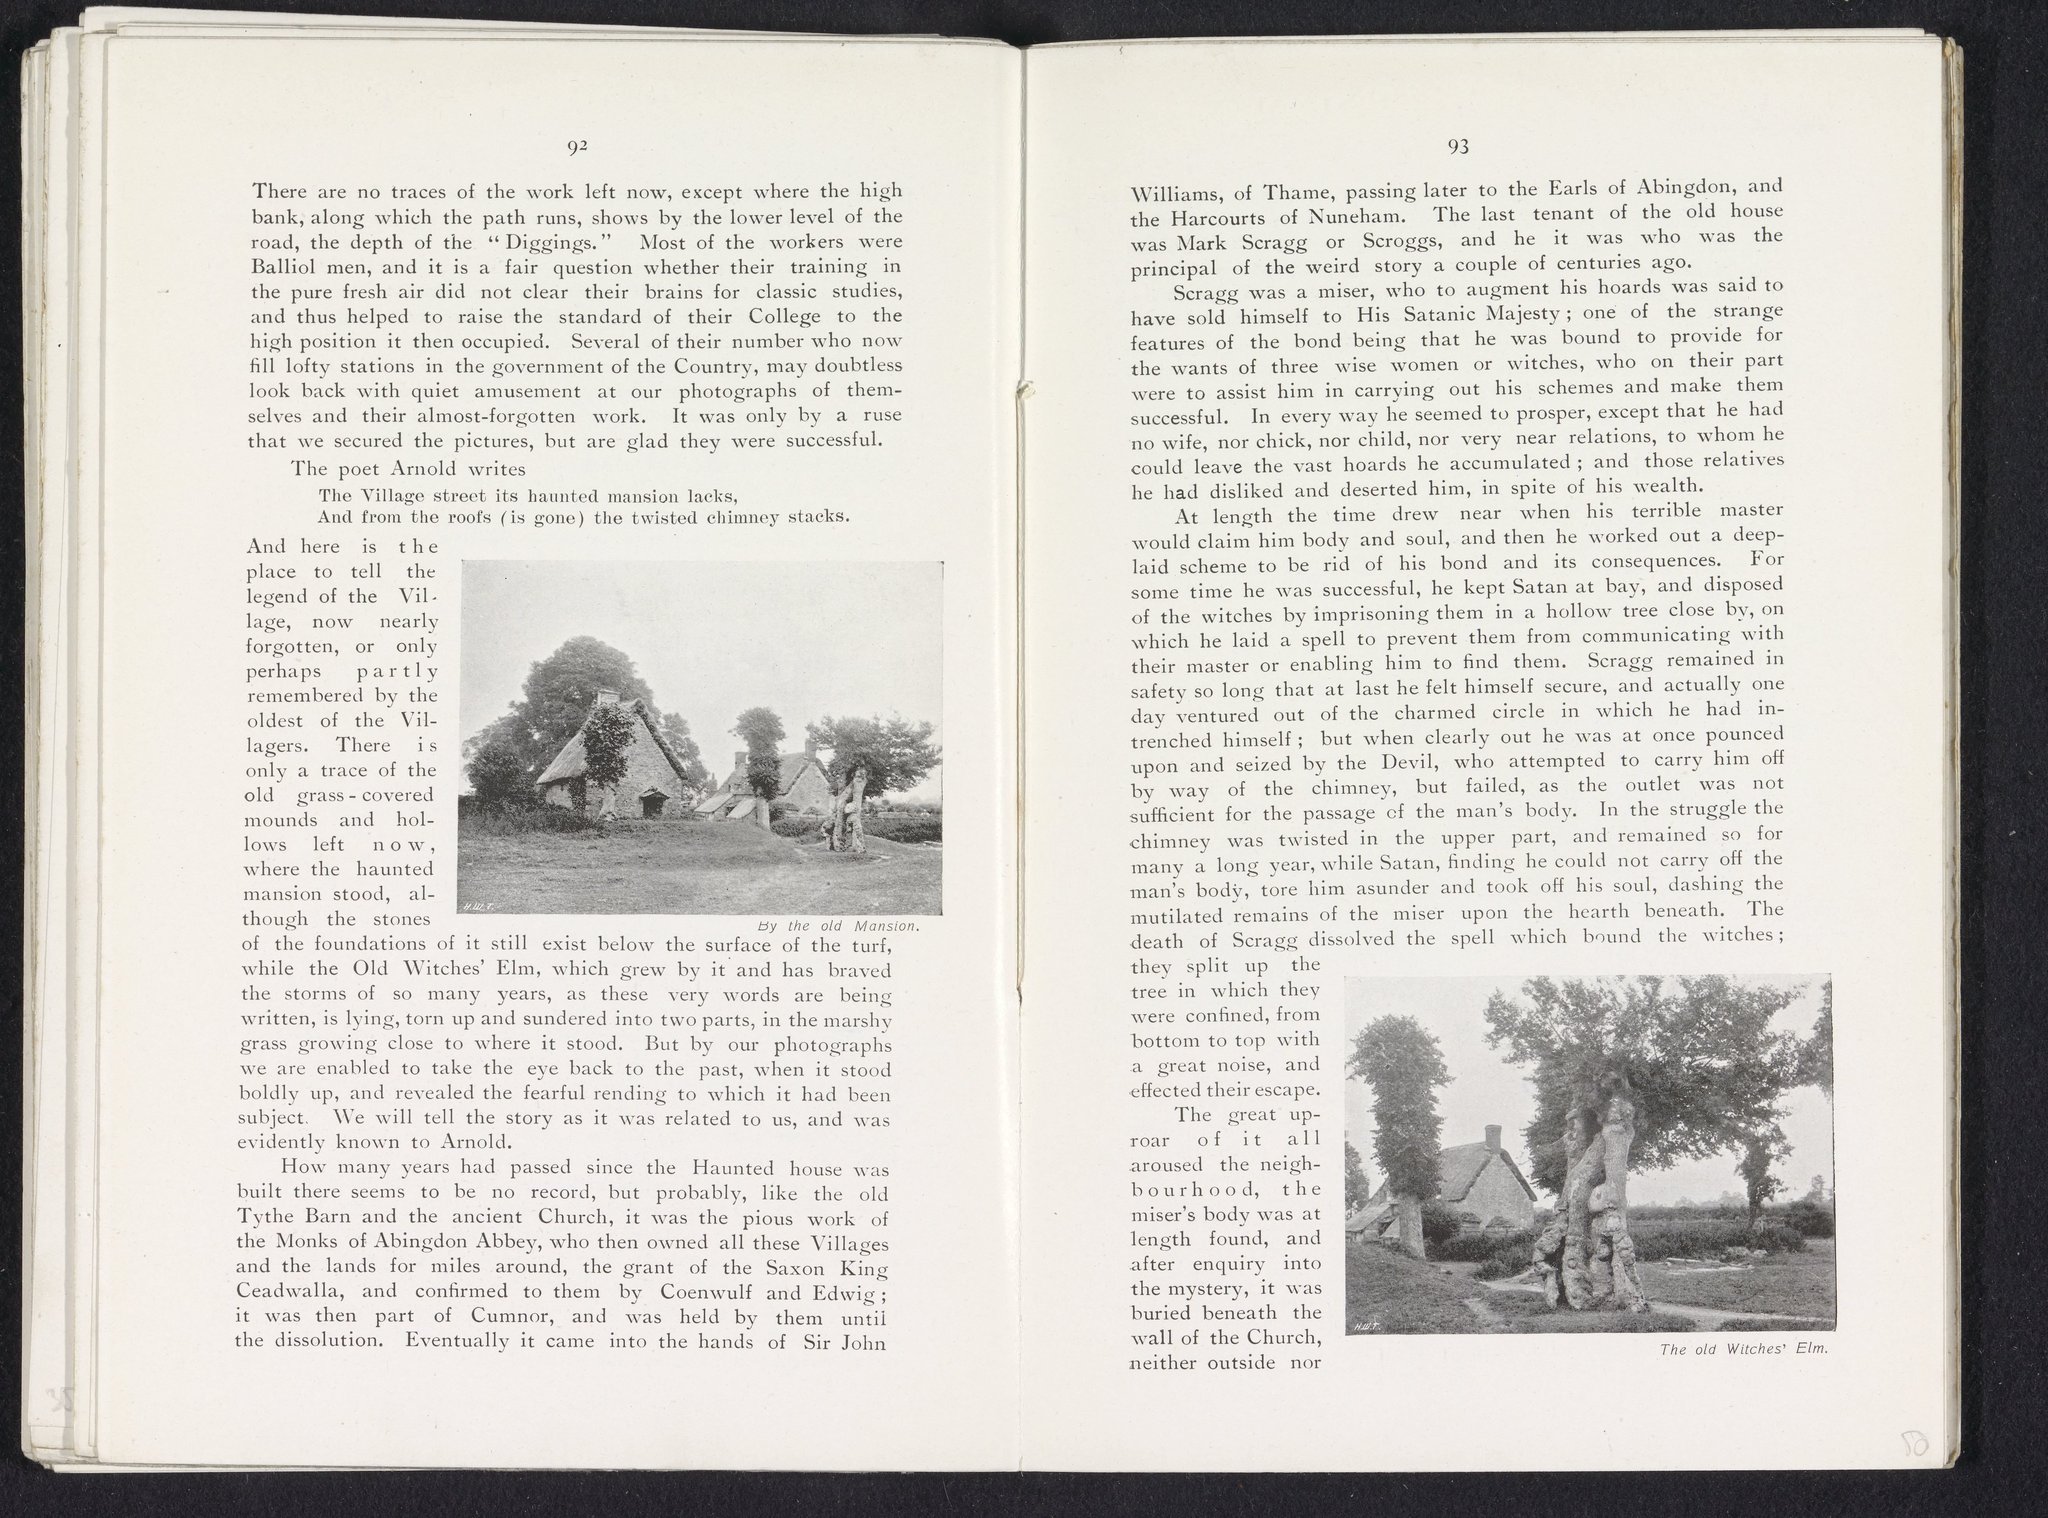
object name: page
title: The old witches' elm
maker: henry w. taunt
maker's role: fotograaf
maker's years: 1842-1922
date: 1907-1912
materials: paper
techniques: autotype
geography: north hinksey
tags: trees: elm